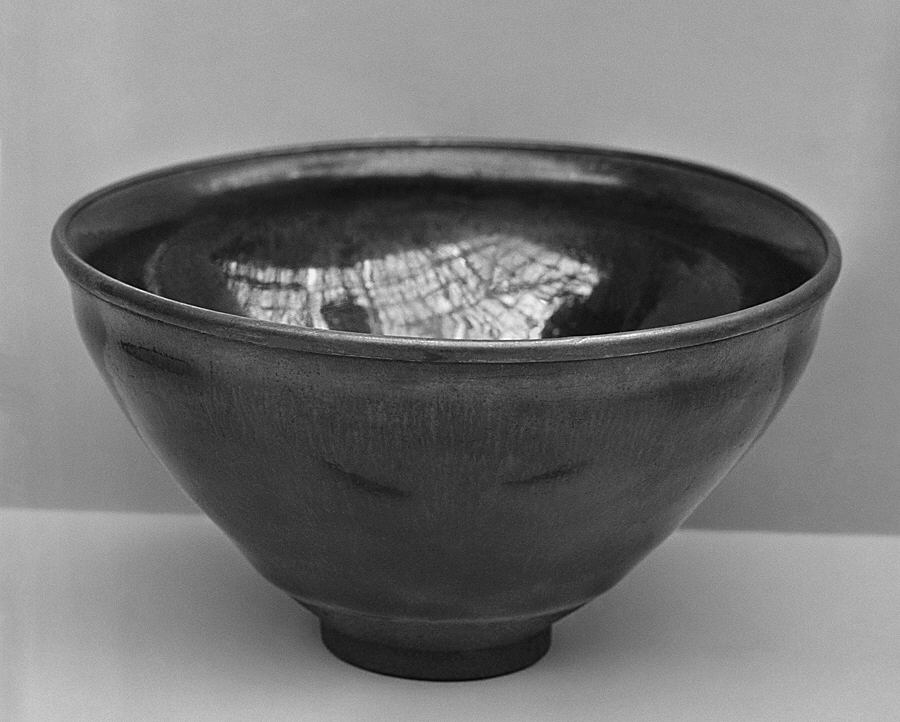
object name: bowl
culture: chinese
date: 960-1279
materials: clay, glaze, metal